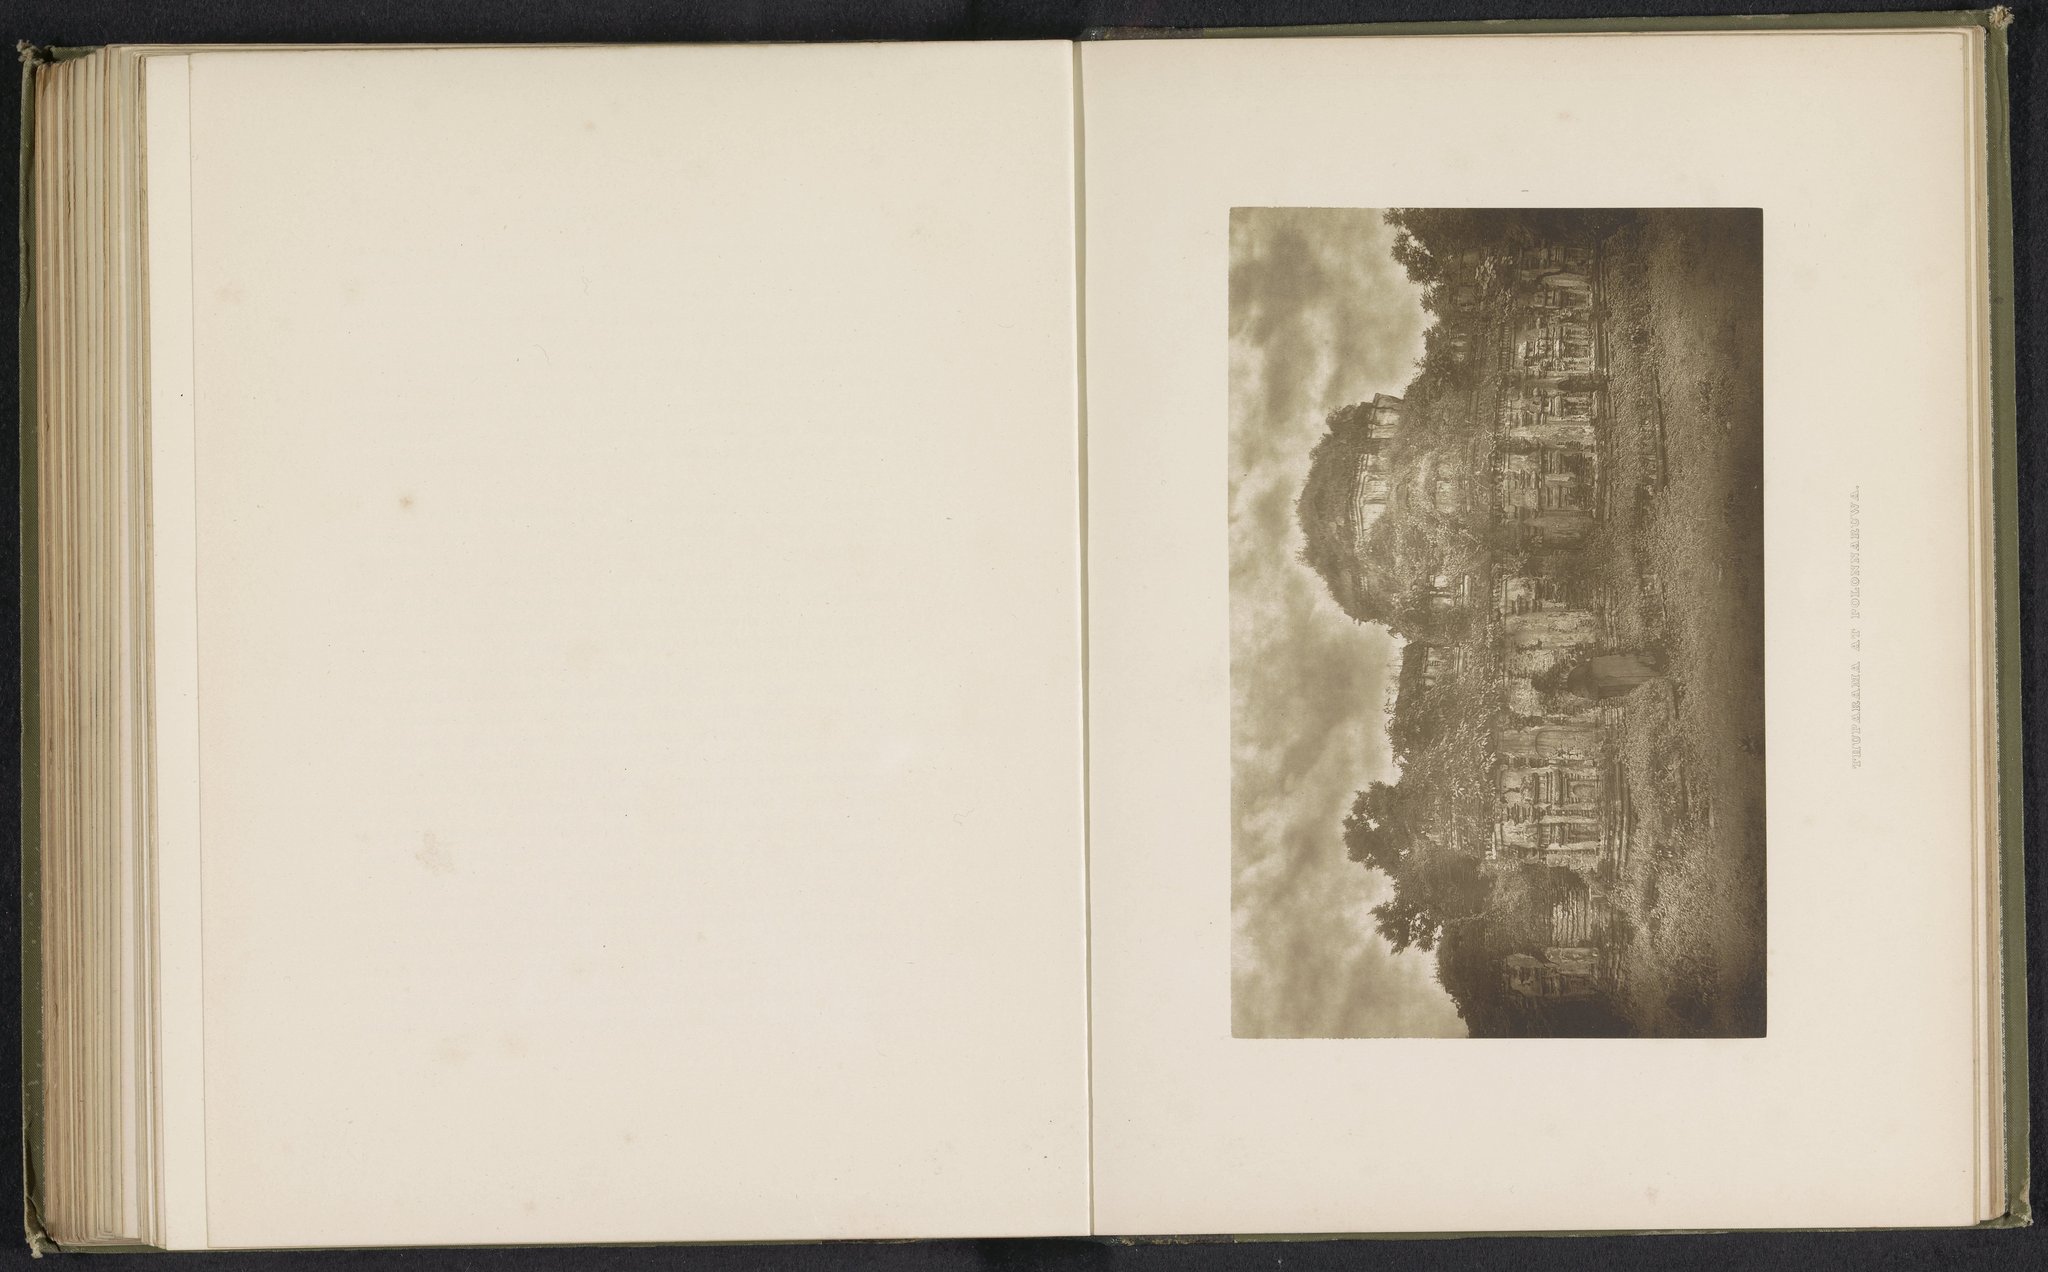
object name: photomechanical print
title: Ruins of the Thuparama temple at Polonnaruwa, Sri Lanka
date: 1896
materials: paper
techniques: woodburygravure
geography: polonnaruwa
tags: temple, shrine ~ hinduism, buddhism, jainism, ruin of a building ~ architecture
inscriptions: title: ‘THUPARAMA AT POLONNARUWA.’